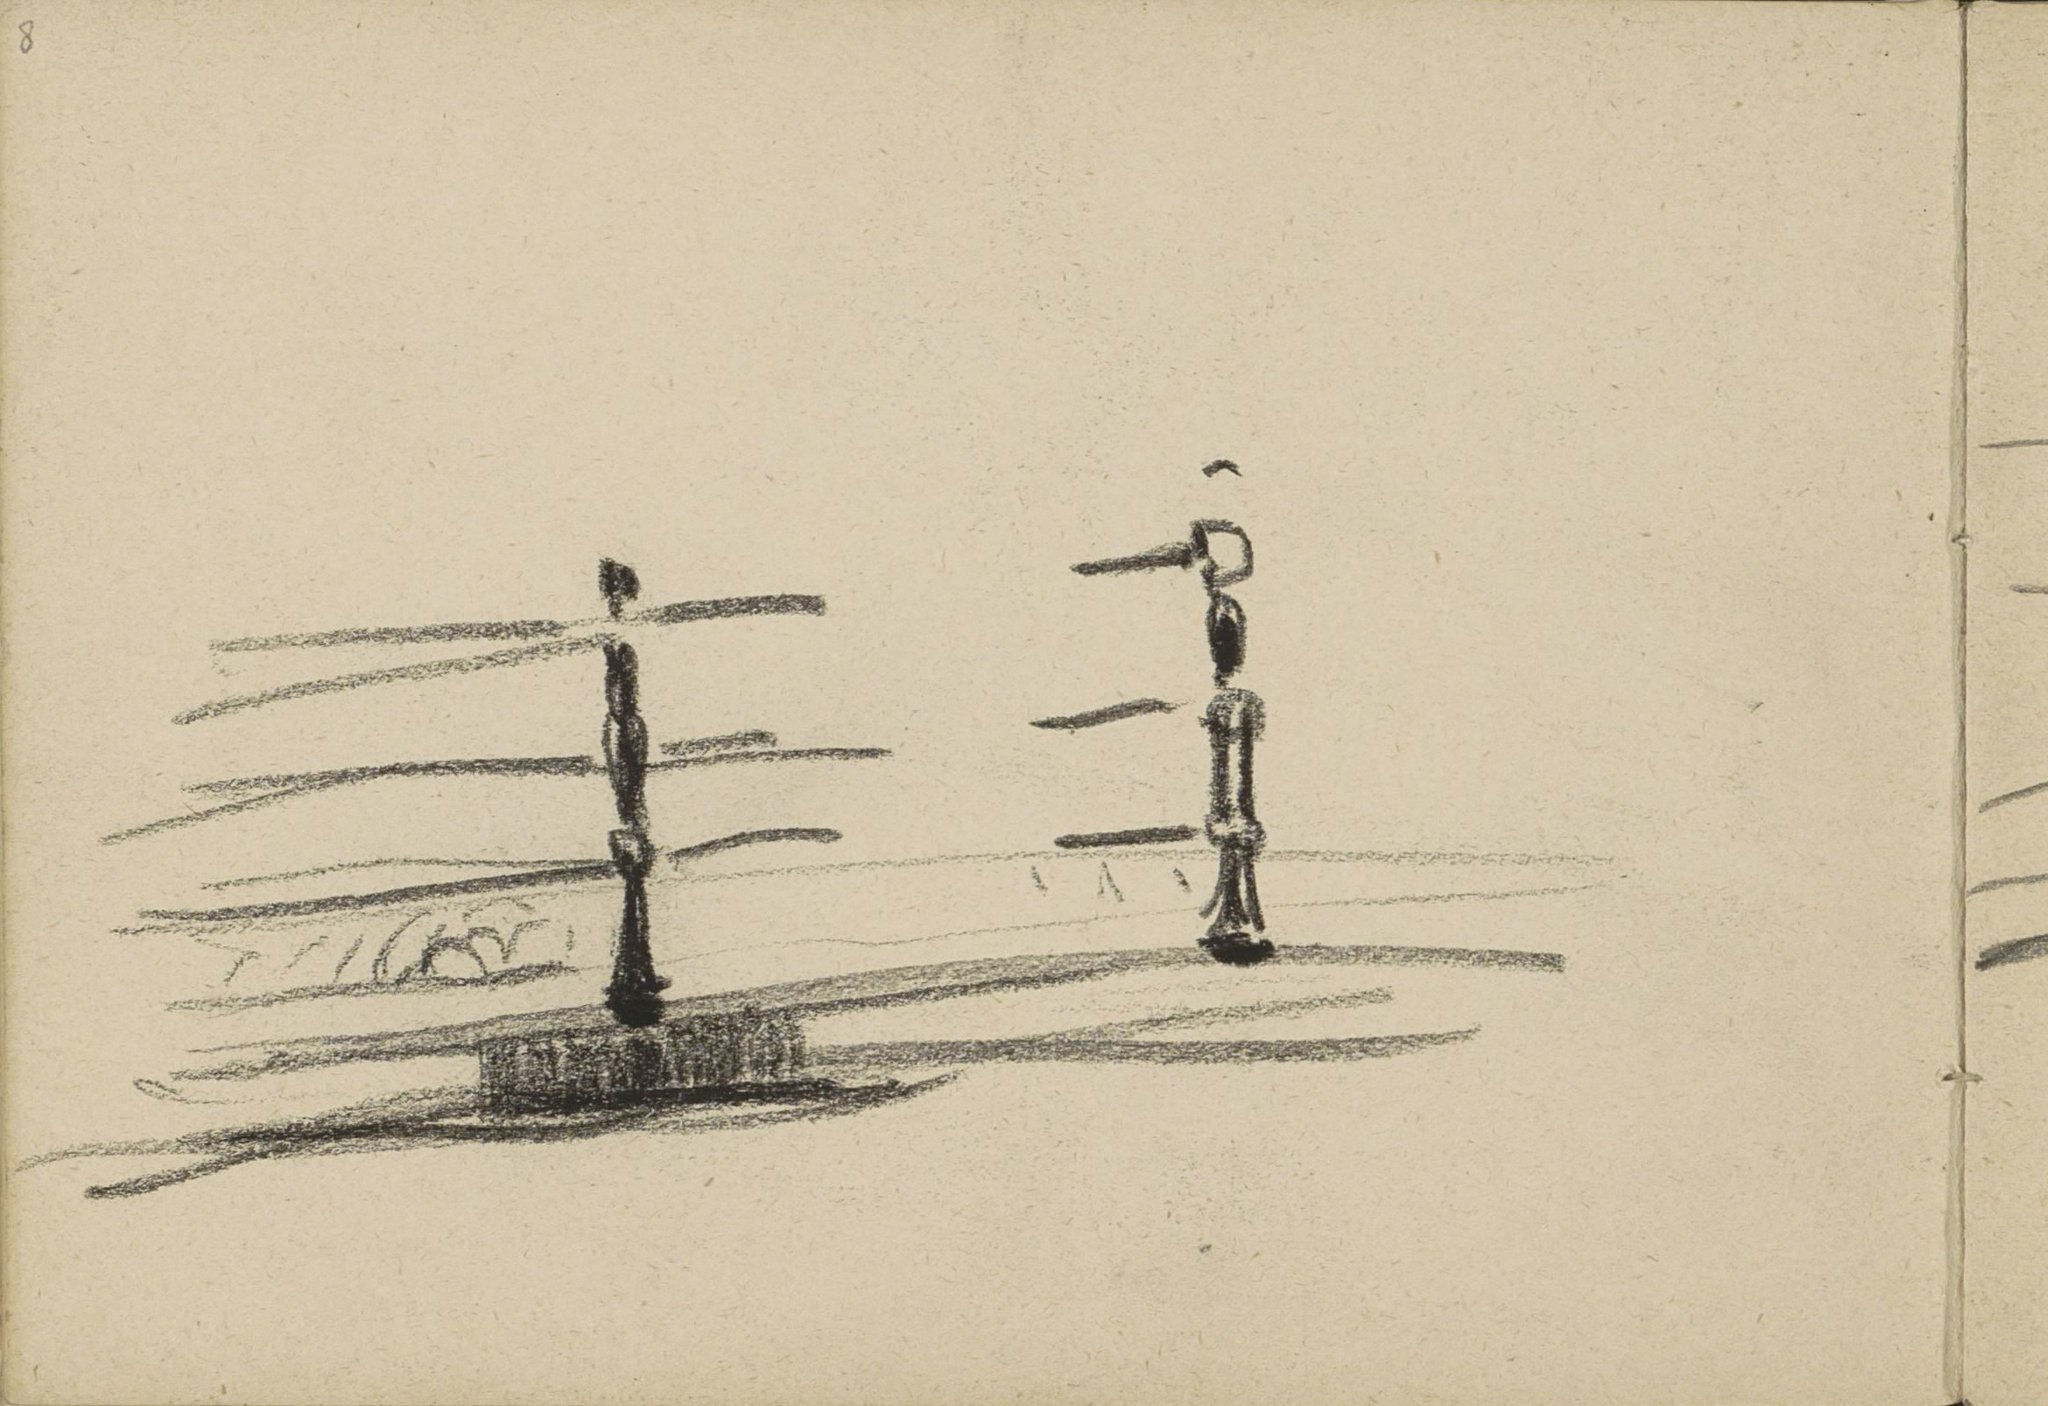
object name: sketchbook leaf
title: Brugleuning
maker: willem witsen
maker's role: draughtsman, painter, print maker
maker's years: 1860-1923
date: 1870-1923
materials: chalk, paper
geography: amsterdam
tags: balustrade, bridge, amsterdam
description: Pagina 8 uit een schetsboek met 16 bladen.